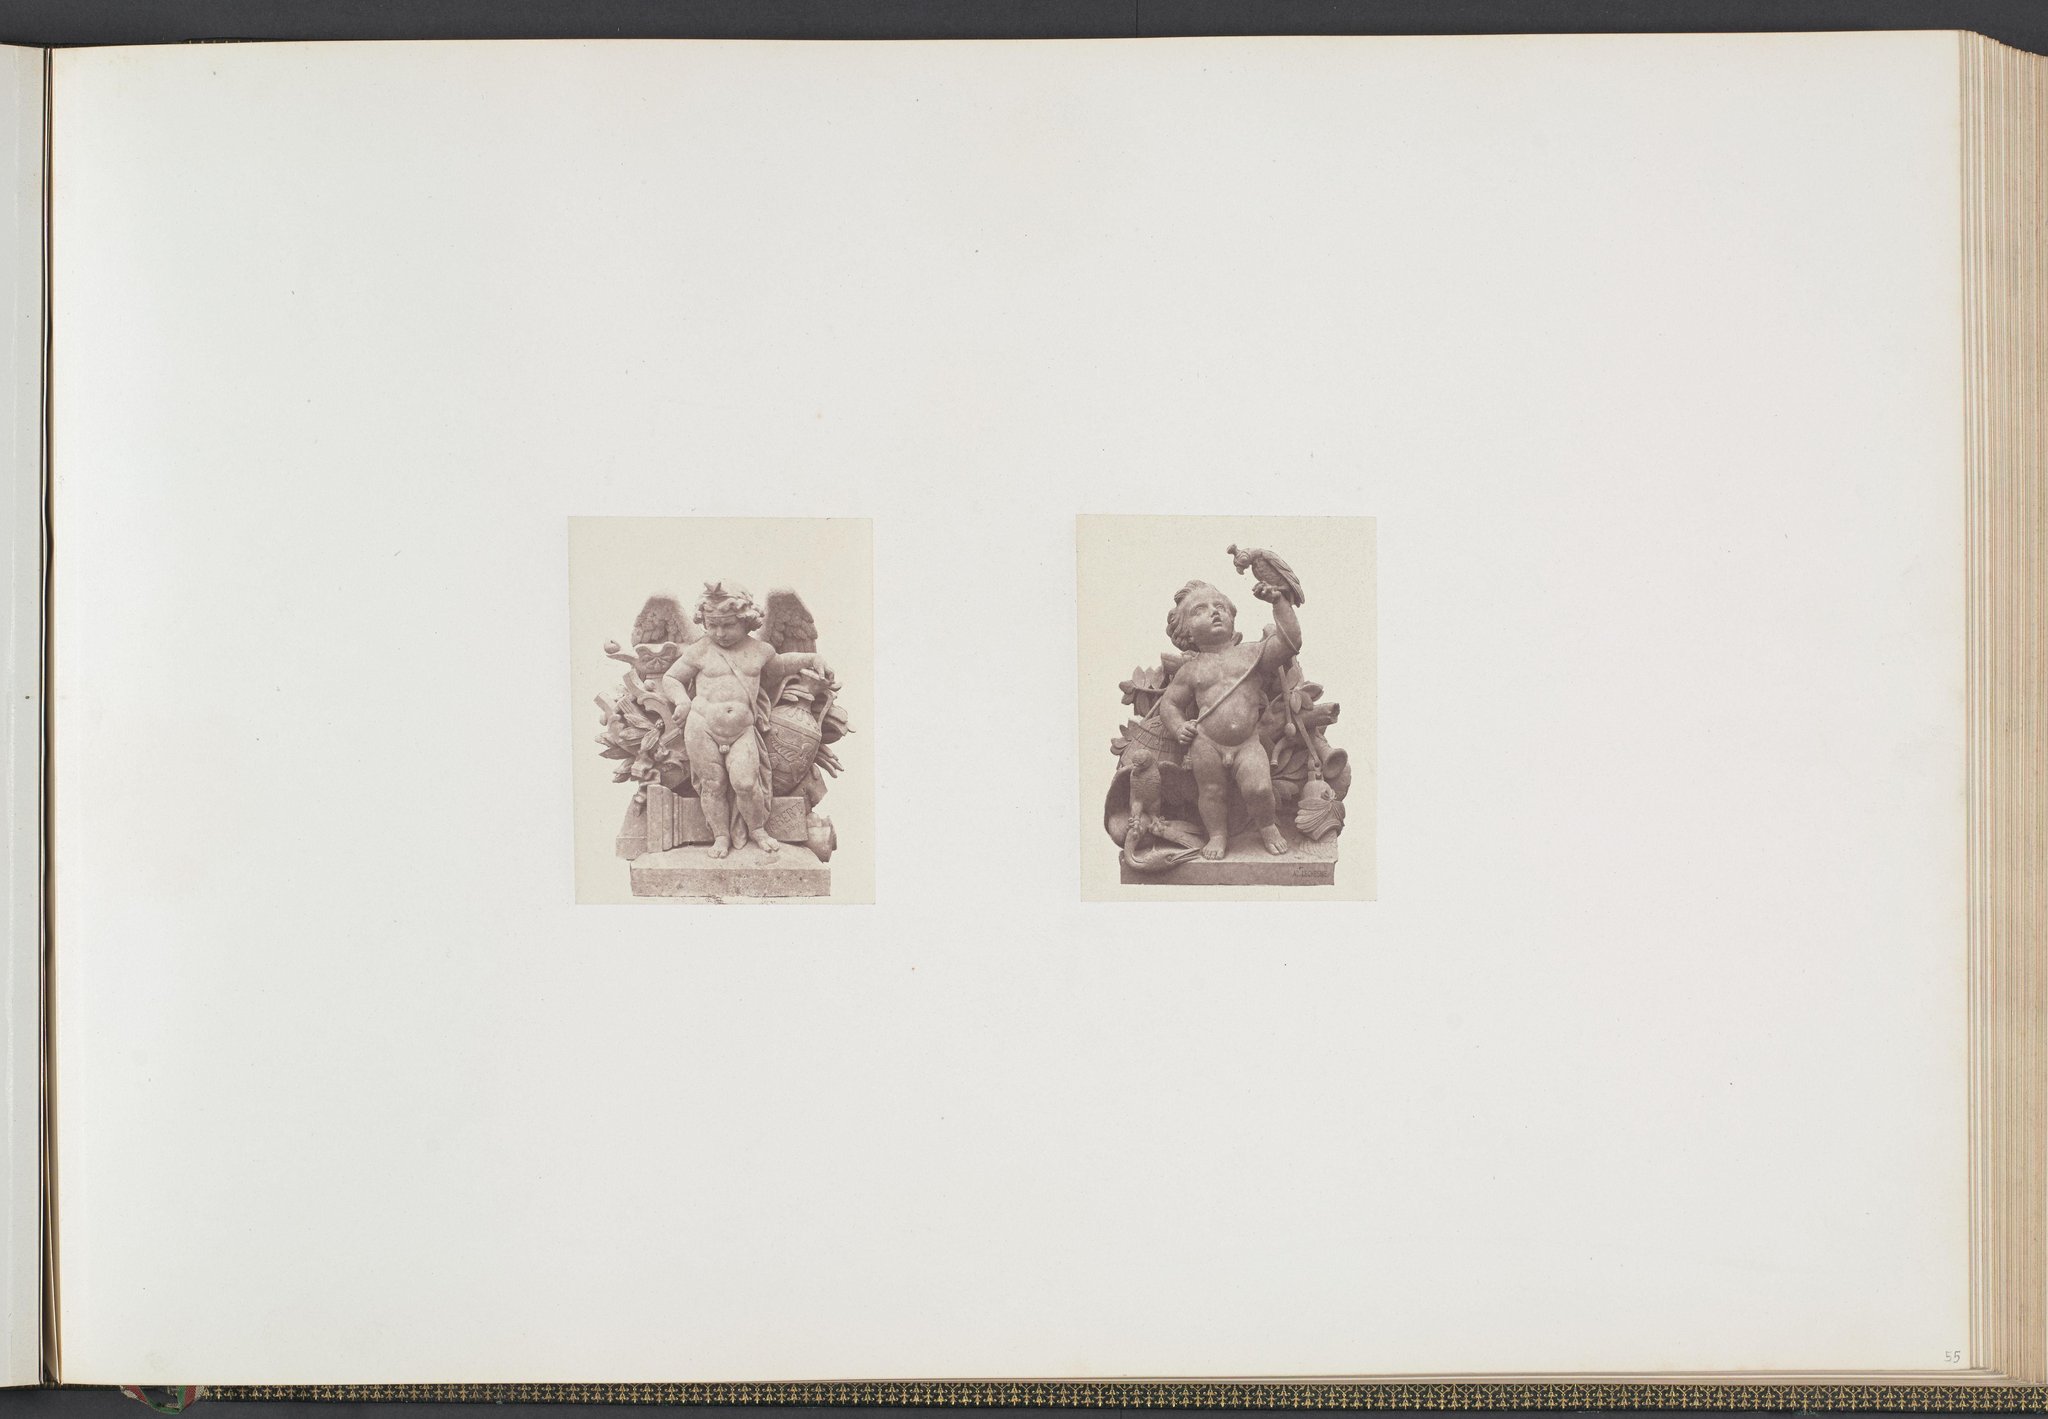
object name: album leaf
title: Gipsmodellen voor beeldhouwwerken op het Palais du Louvre: links "L'Art étrusque" door Pierre Hébert en rechts "La Chasse" door Auguste Jean Baptiste Lechesne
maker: édouard denis baldus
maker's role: fotograaf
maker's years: 1813-1889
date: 1855-1857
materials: paper, photographic support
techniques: salted paper print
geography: paris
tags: piece of sculpture, reproduction of a piece of sculpture, permanent exhibition, museum, paris, tuileries palace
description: Onderdeel van Réunion des Tuileries au Louvre 1852-1857, album 2.